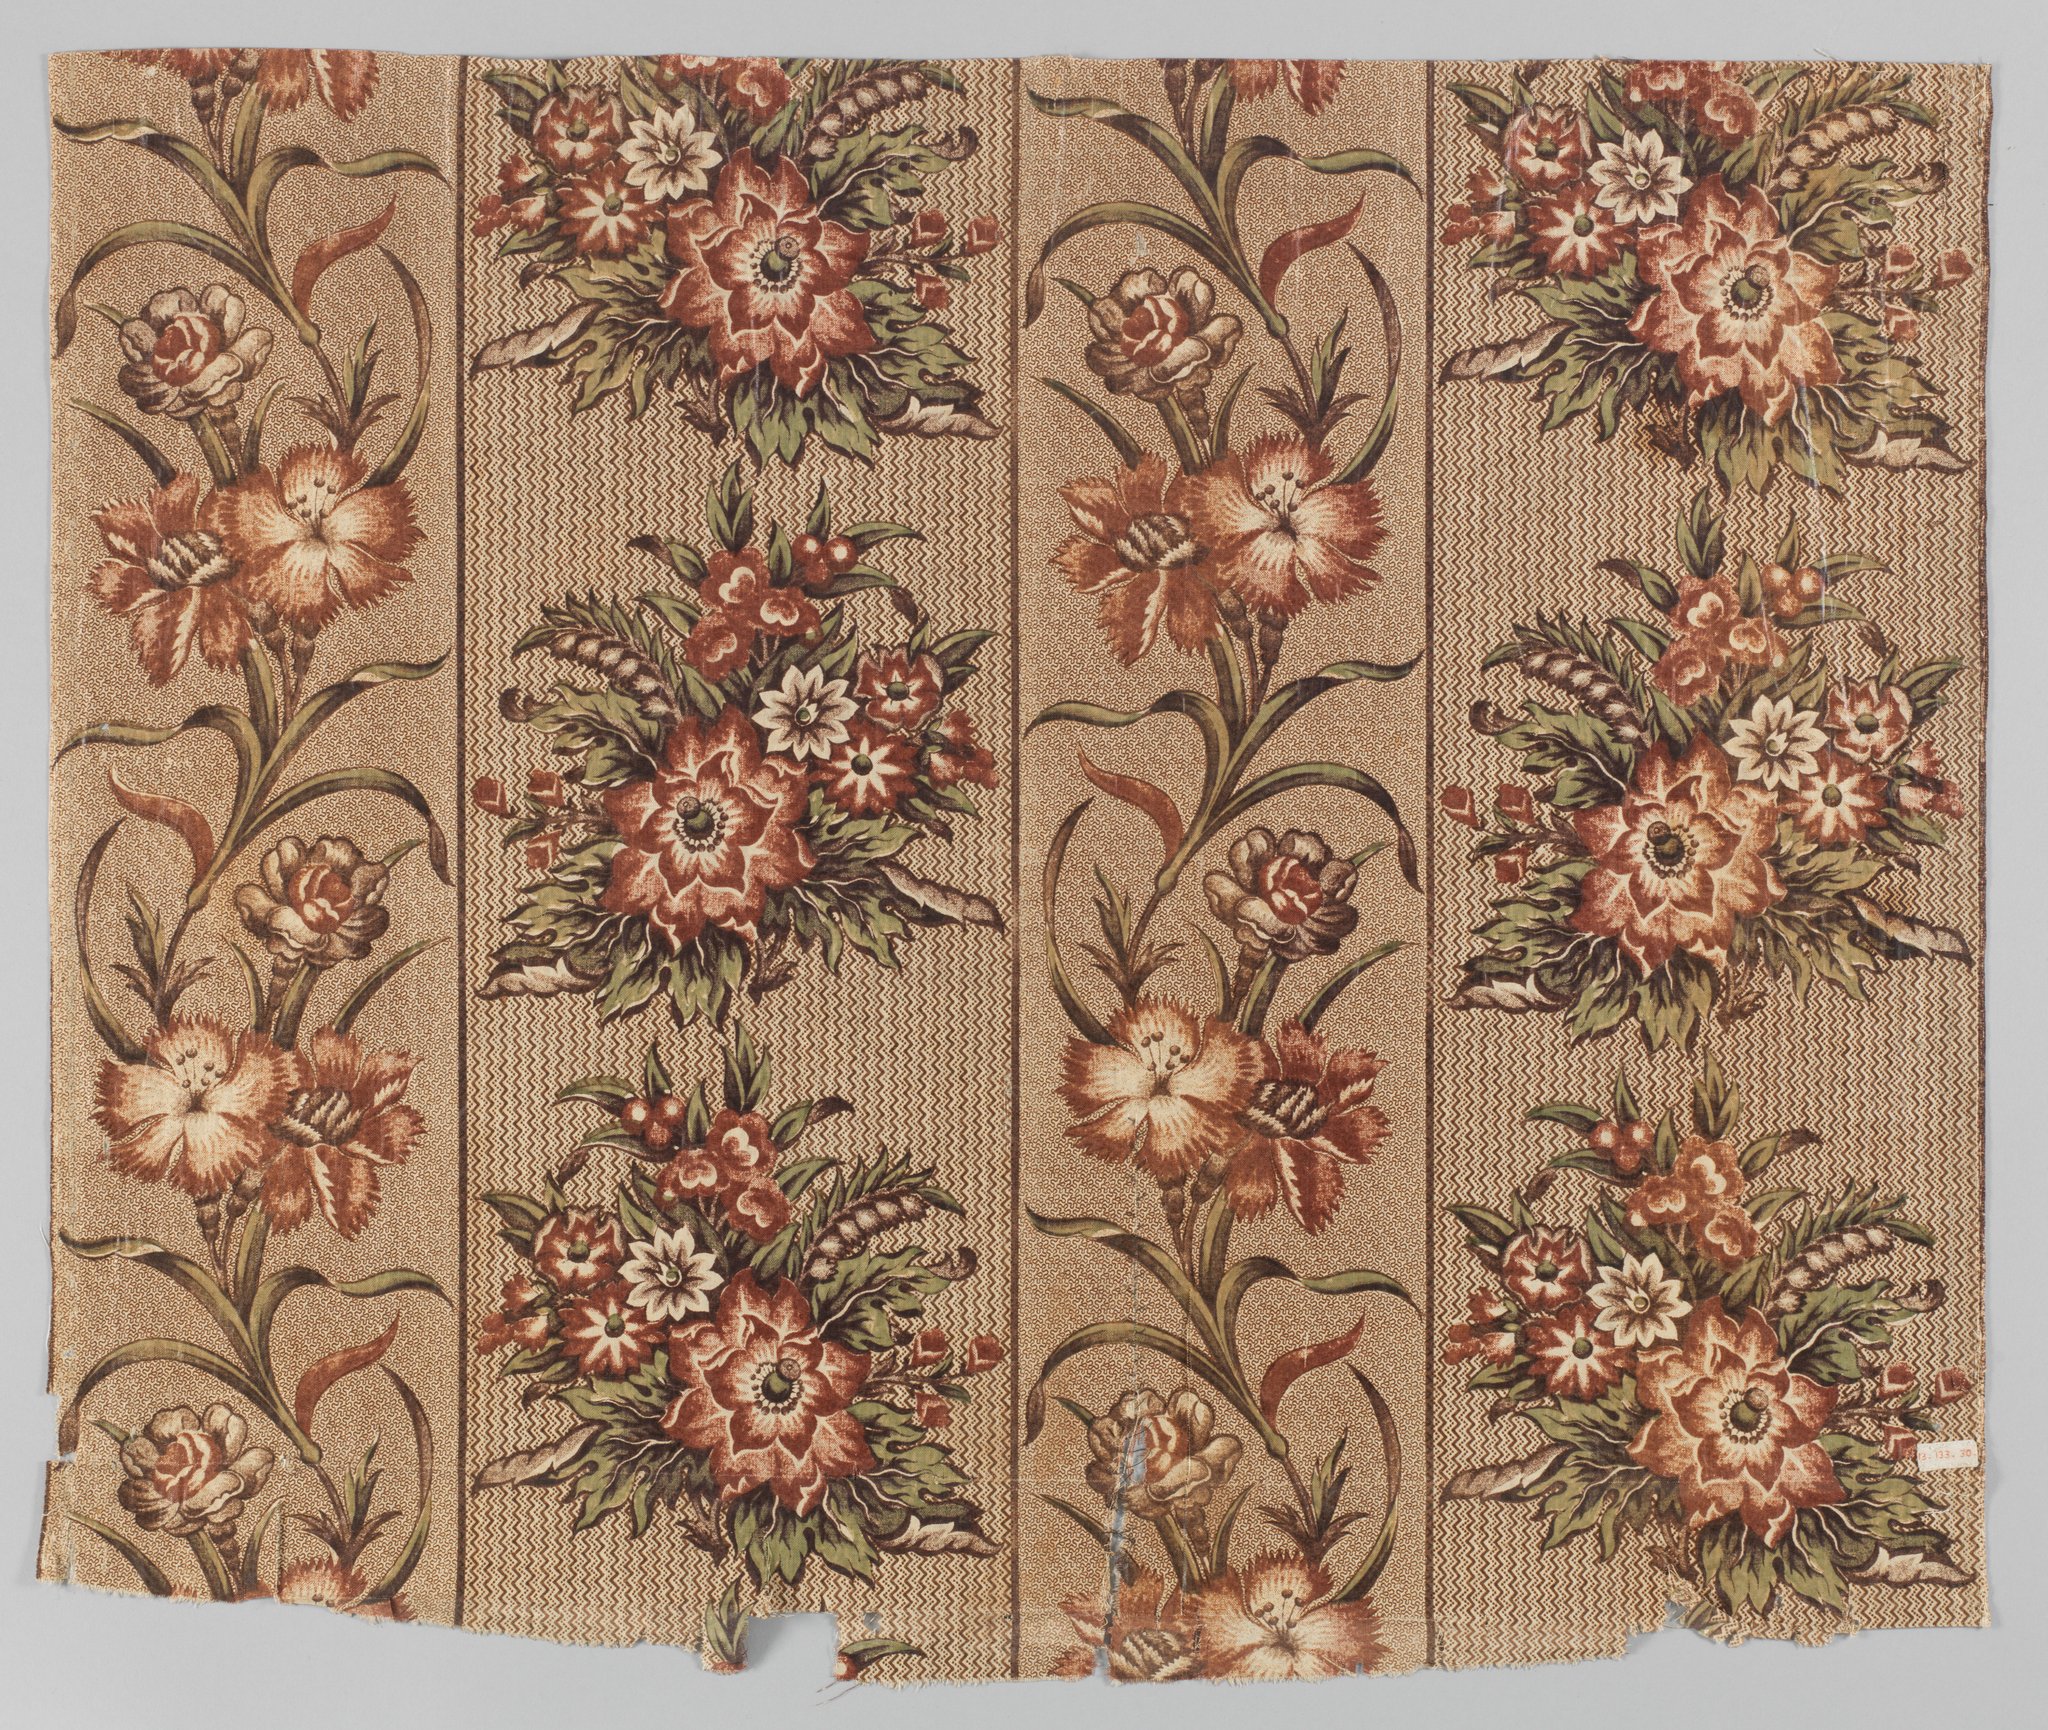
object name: piece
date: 1840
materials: cotton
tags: flowers